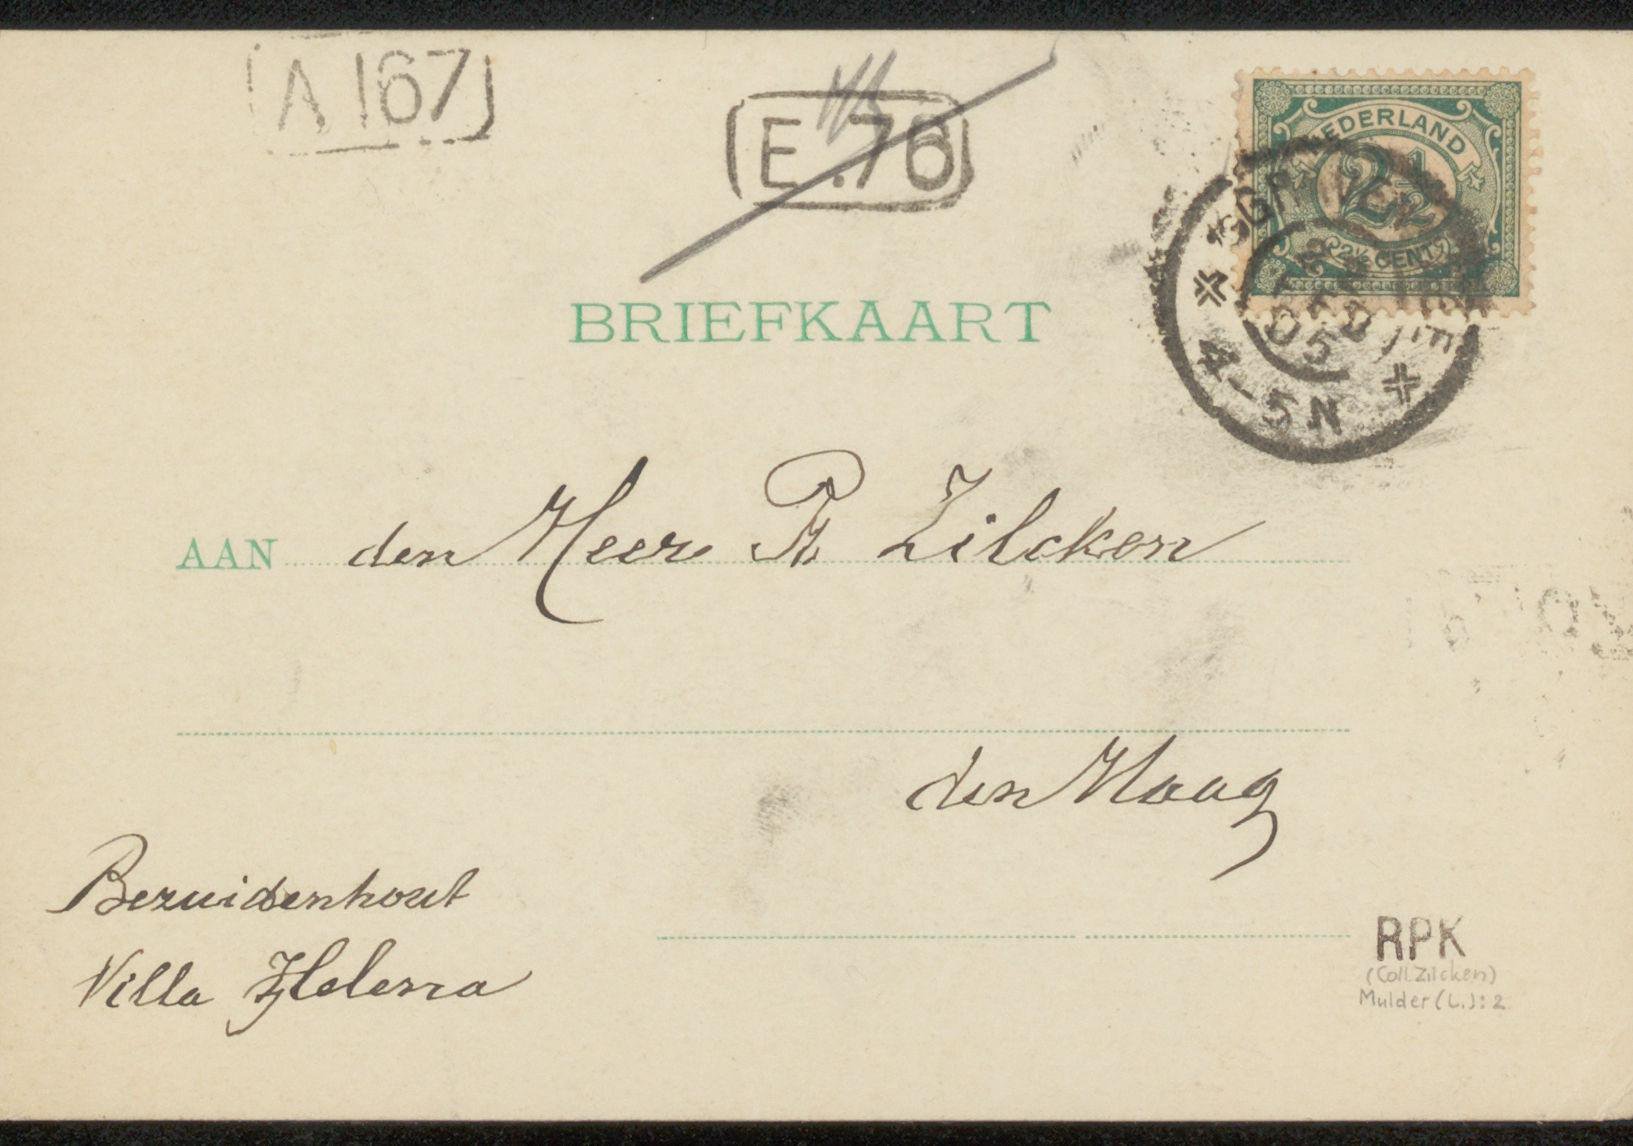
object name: postcard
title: Briefkaart aan Philip Zilcken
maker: lodewijk mulder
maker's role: painter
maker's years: 1822-1907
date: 1905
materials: cardboard, ink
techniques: pen, writing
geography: the hague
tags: print maker, hendrik willem mesdag, draughtsman, philip zilcken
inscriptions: collector's mark: ‘RPK’